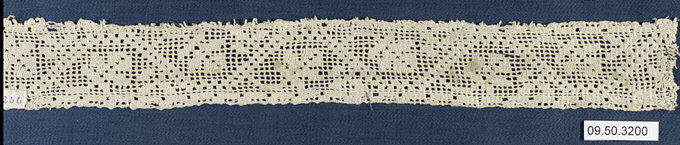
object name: strip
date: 1601-1700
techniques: embroidery